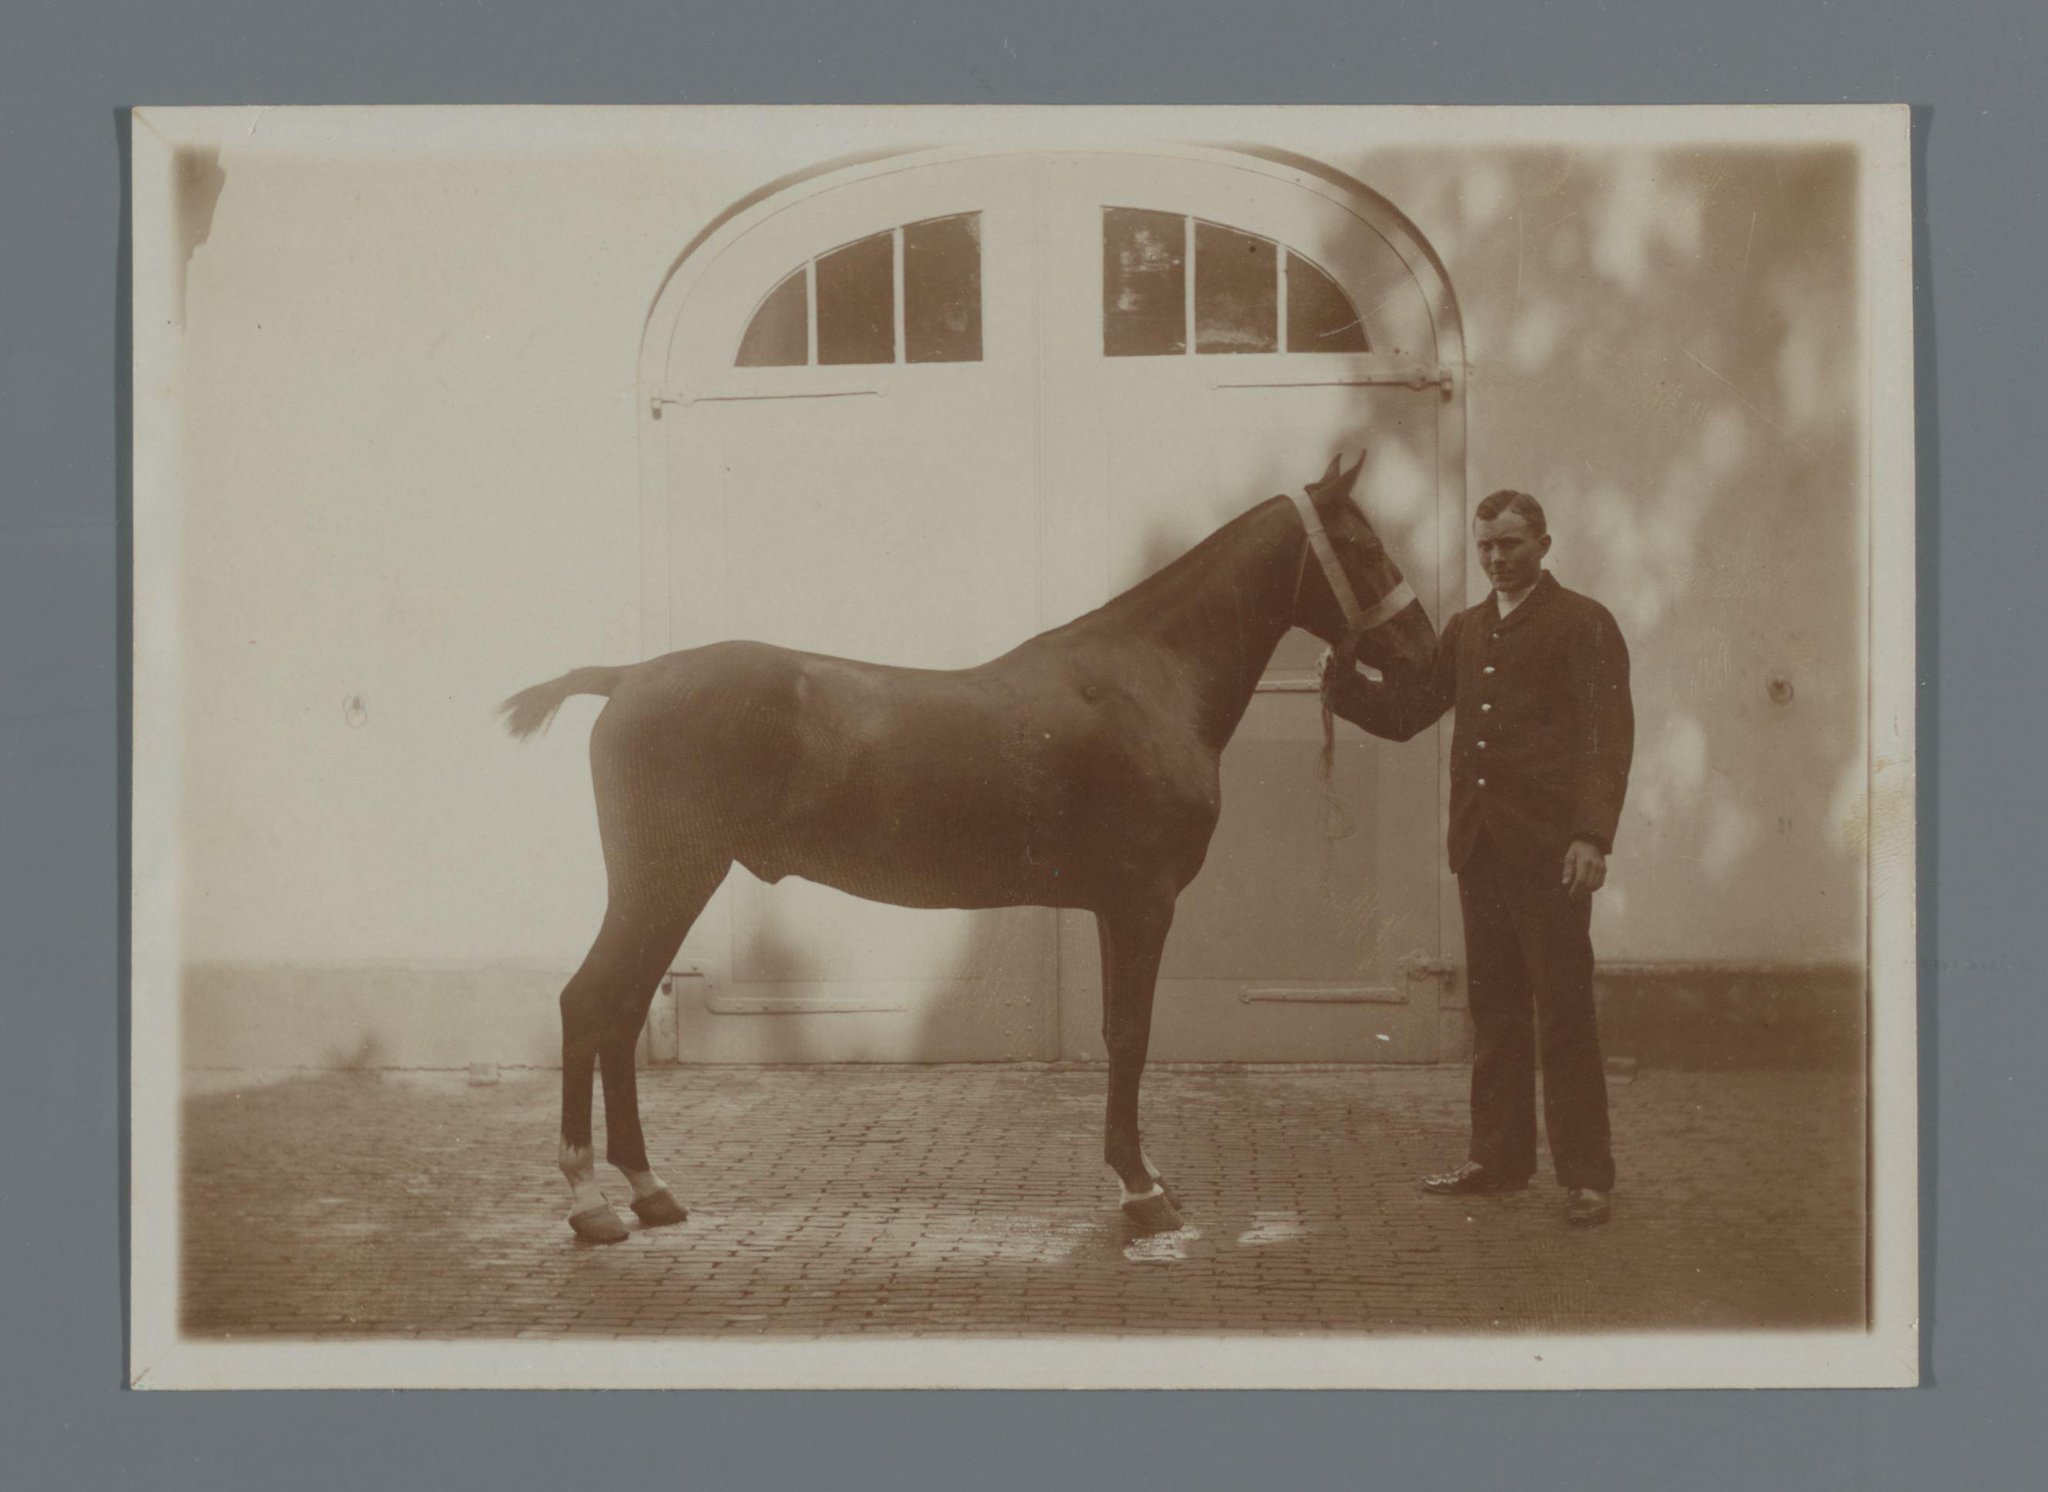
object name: photograph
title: Het paard Bobbie met man aan teugel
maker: hendrik herman van den berg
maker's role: amateurfotograaf, jurist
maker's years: 1875-1944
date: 1896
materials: cardboard, photographic support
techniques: collodion silver print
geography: baarn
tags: leading a horse by the reins; rider beside his horse